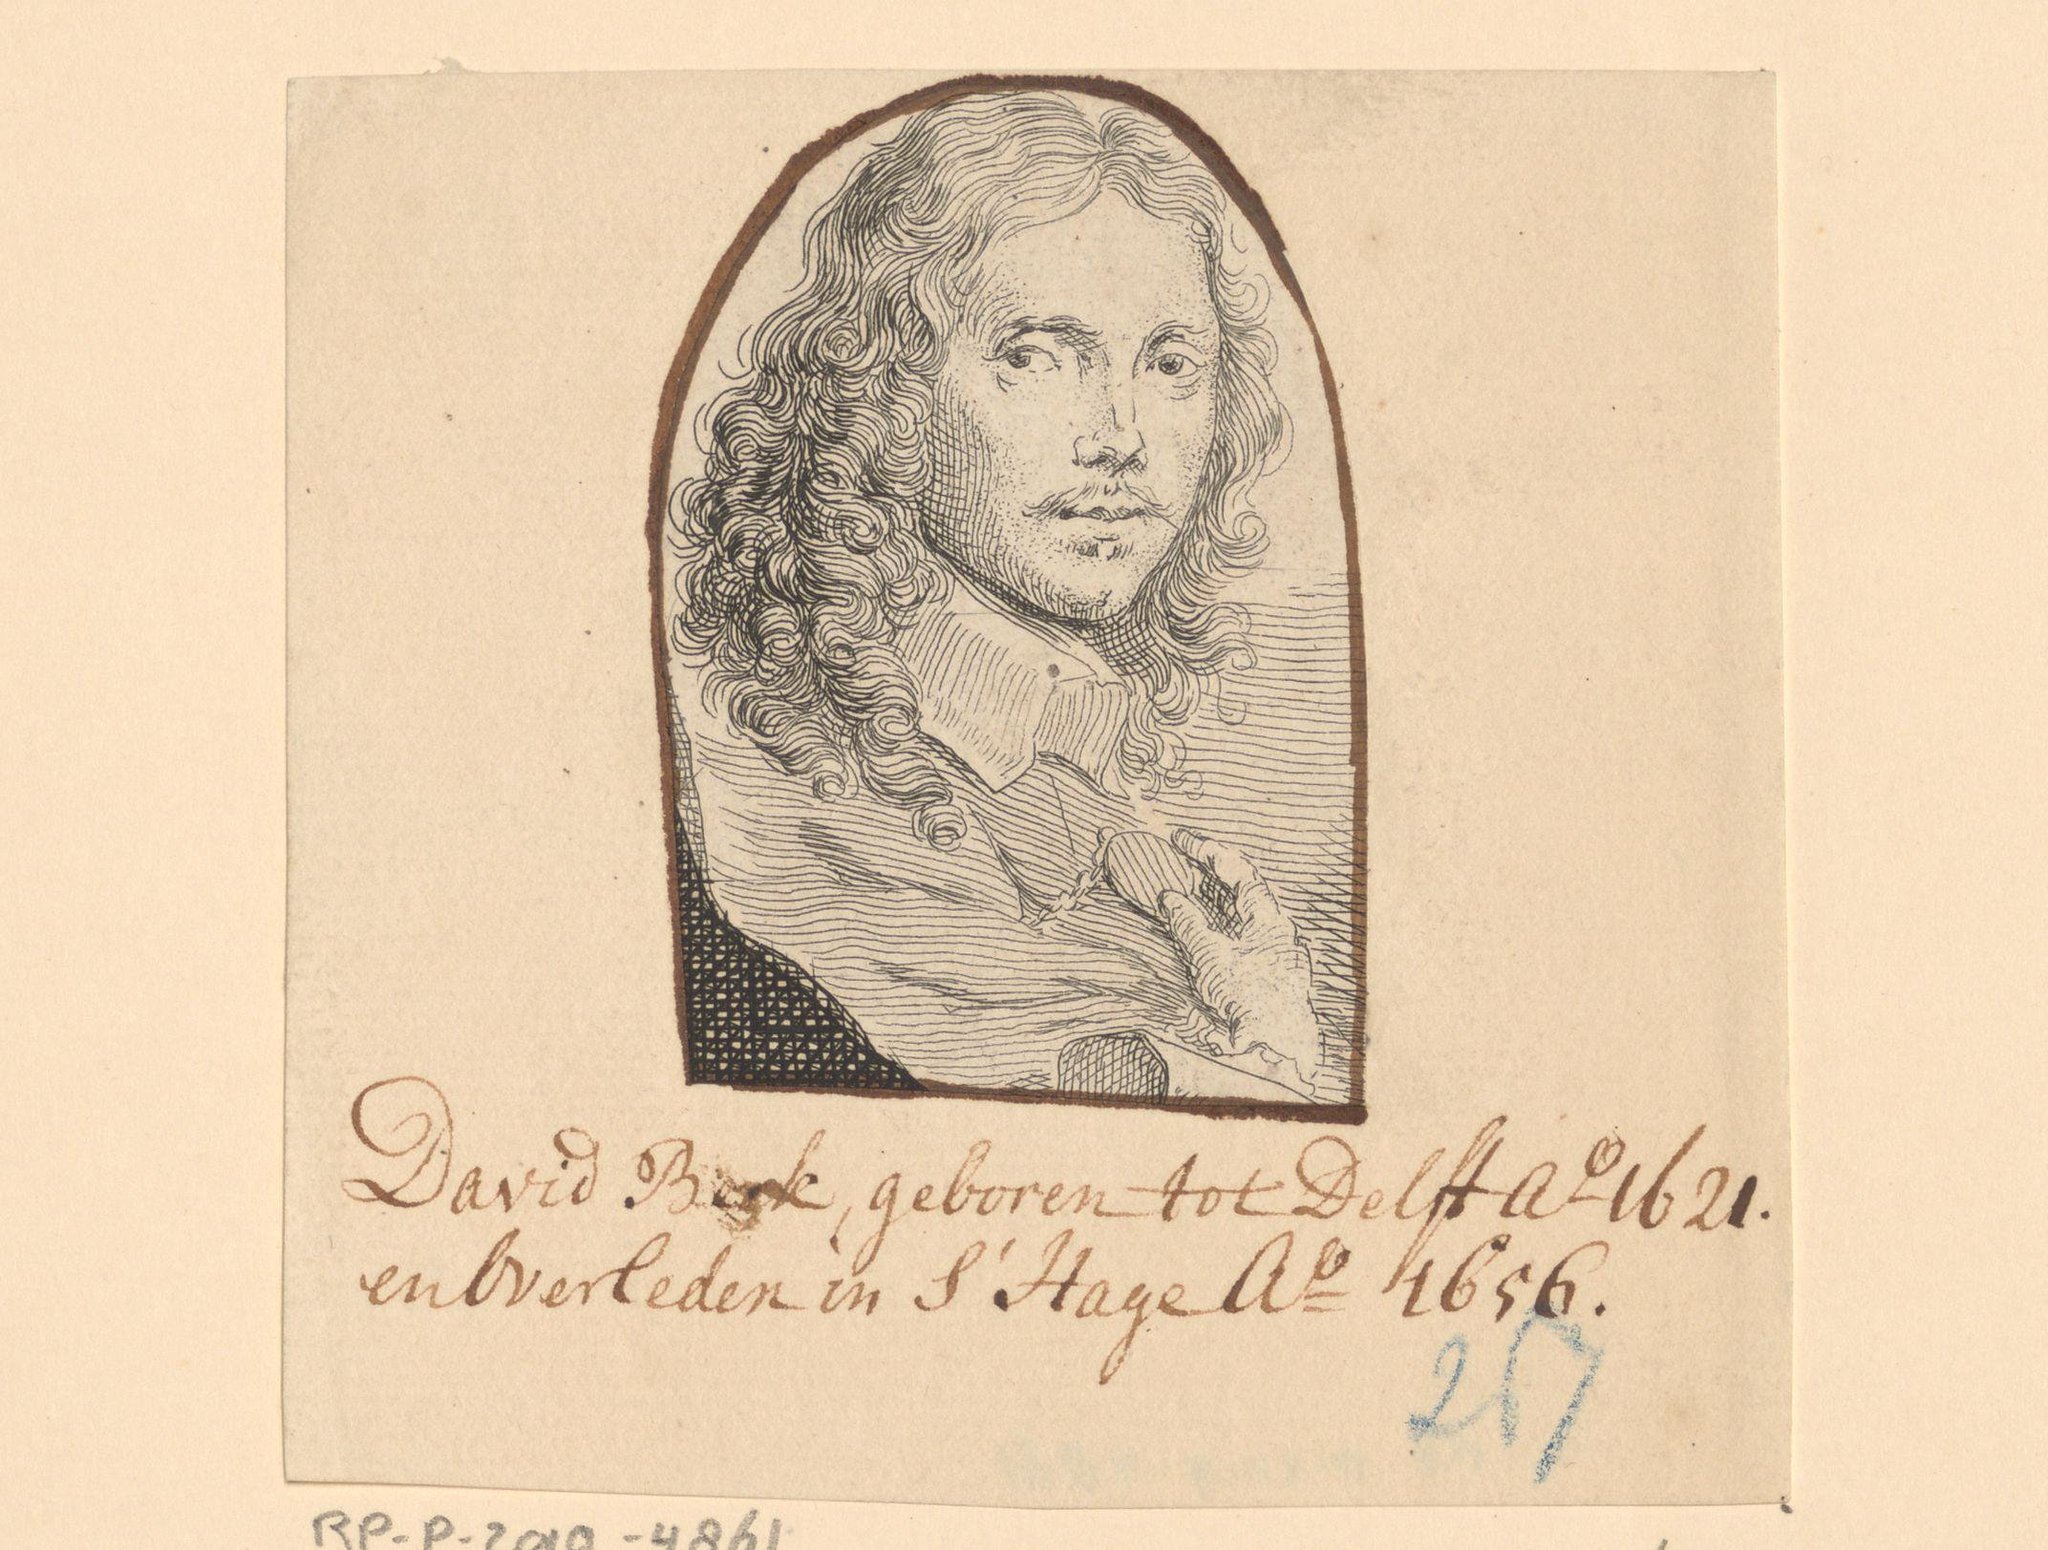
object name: print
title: Portret van David Beck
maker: jacob houbraken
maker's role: draughtsman, print maker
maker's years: 1698-1780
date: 1718-1721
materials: paper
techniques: engraving, etching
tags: delft, painter, print maker, david beck, historical persons, portrait, self-portrait of painter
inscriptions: inscription: ‘David Beck, geboren tot Delft [...]’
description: Prent uit: Houbraken, Arnold. De groote schouburgh der Nederlantsche konstschilders en schilderessen (...). Den Haag: s.n., 1718-1721, dl. 2.